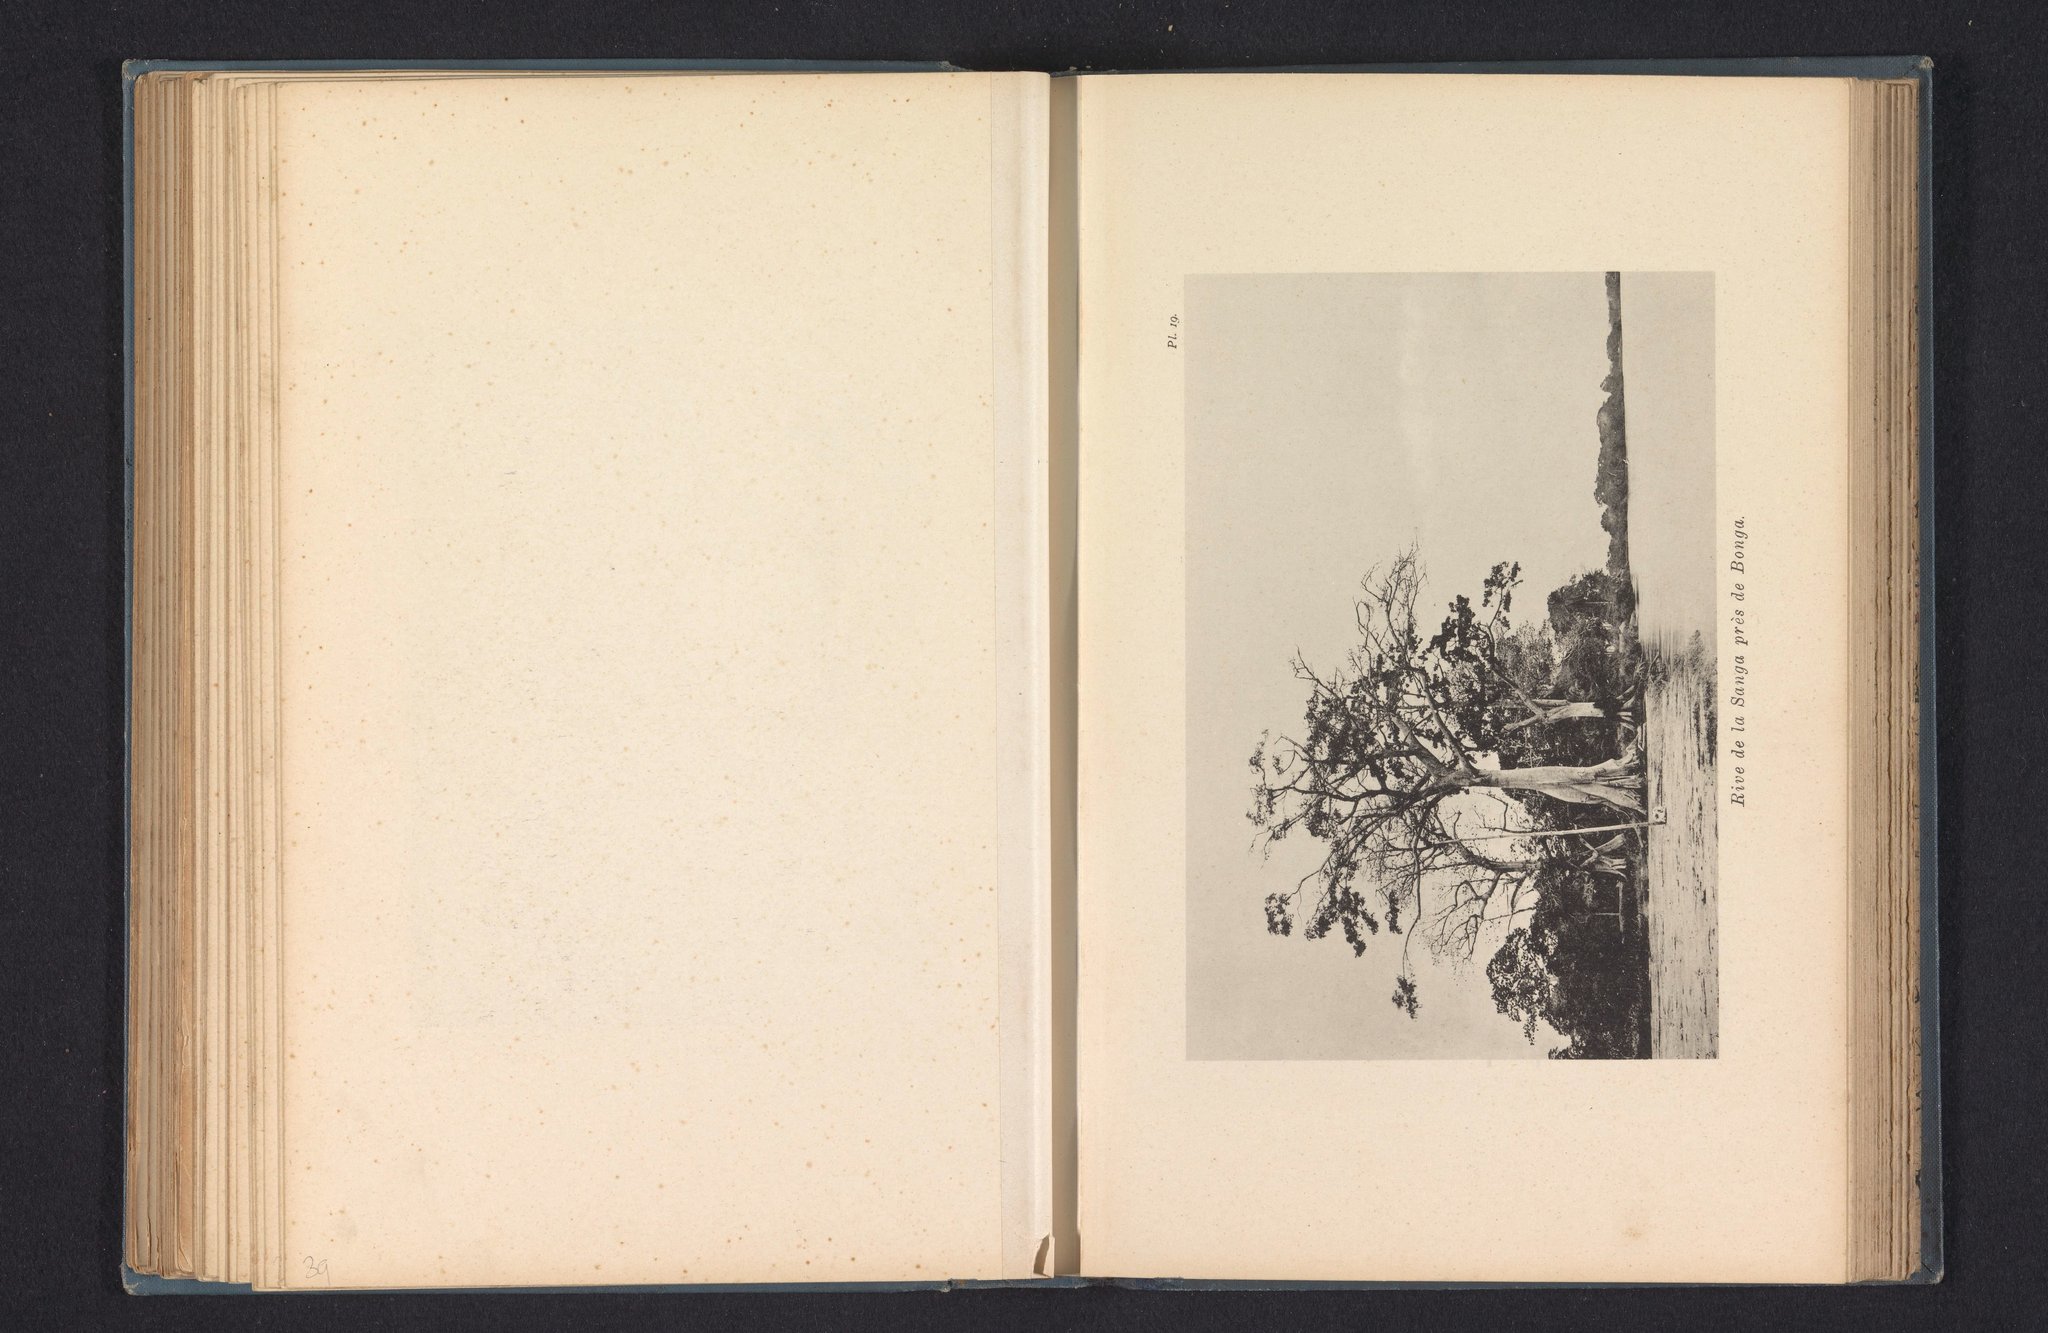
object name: page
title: Rive de la Sanga près de Bonga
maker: franz thonner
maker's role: botanicus, ontdekkingsreiziger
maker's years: 1863-1928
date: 1896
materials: paper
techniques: photograph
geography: dresden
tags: river bank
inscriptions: number: ‘Pl. 19.’